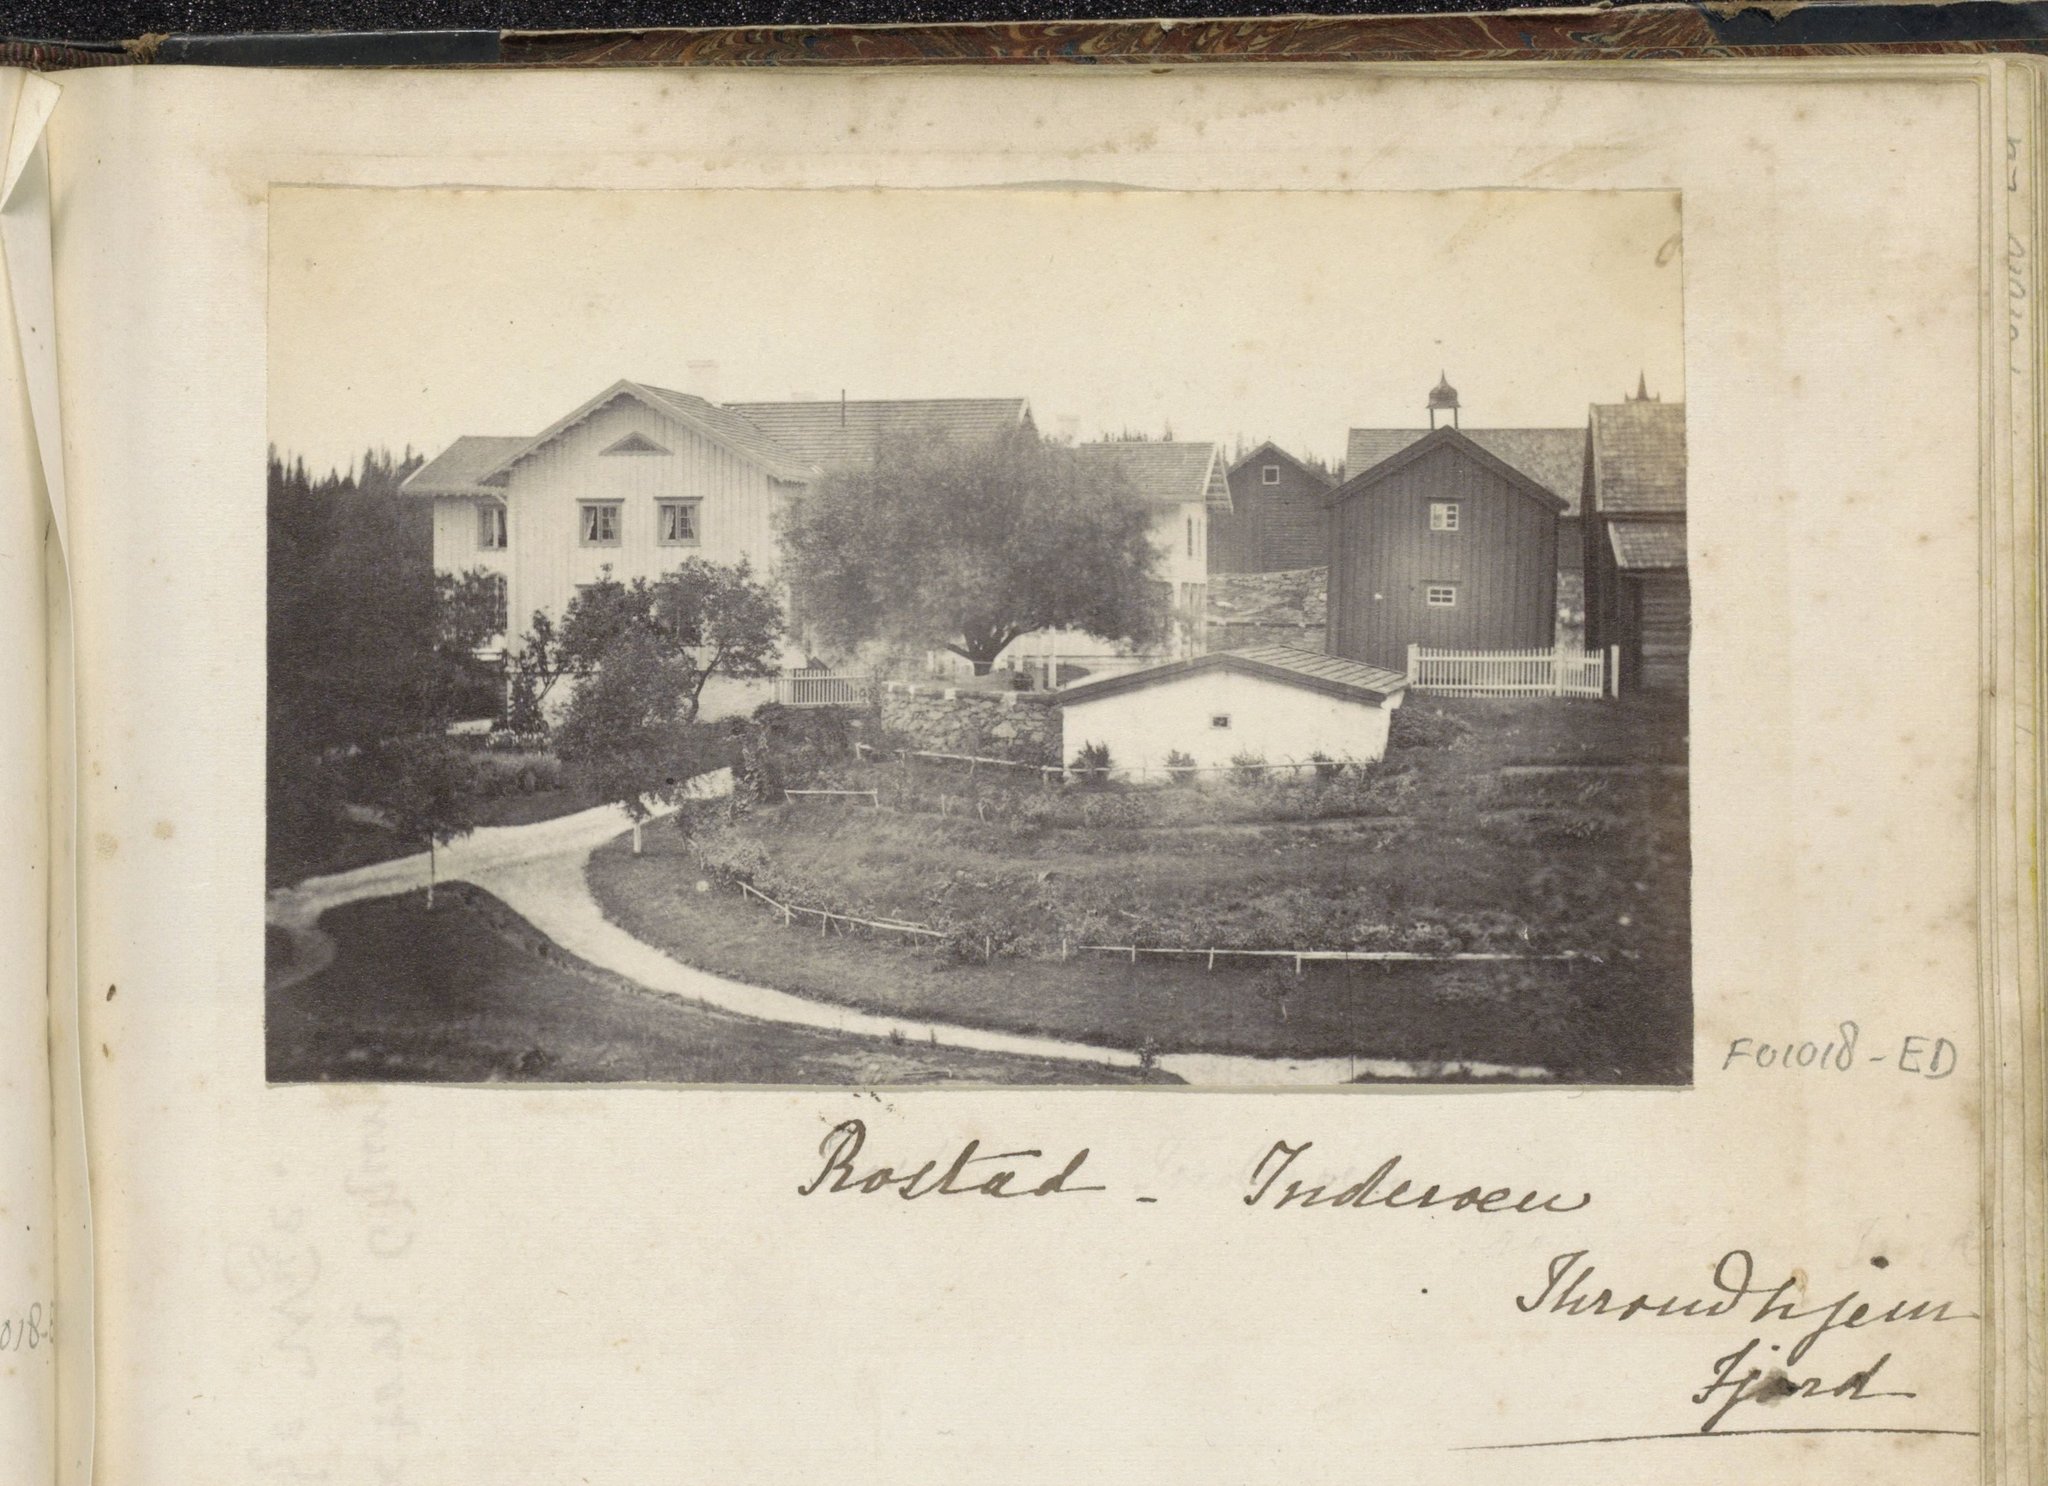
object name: photograph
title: Rostad-Inderoen Trondhjem Fjord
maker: Anonymous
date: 1860-1870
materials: paper, photographic support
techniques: albumen print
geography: inderøy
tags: public road in village, exterior ~ representation of a building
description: Onderdeel van Engels familiealbum met foto's van personen, reizen, cricket en kunstwerken.